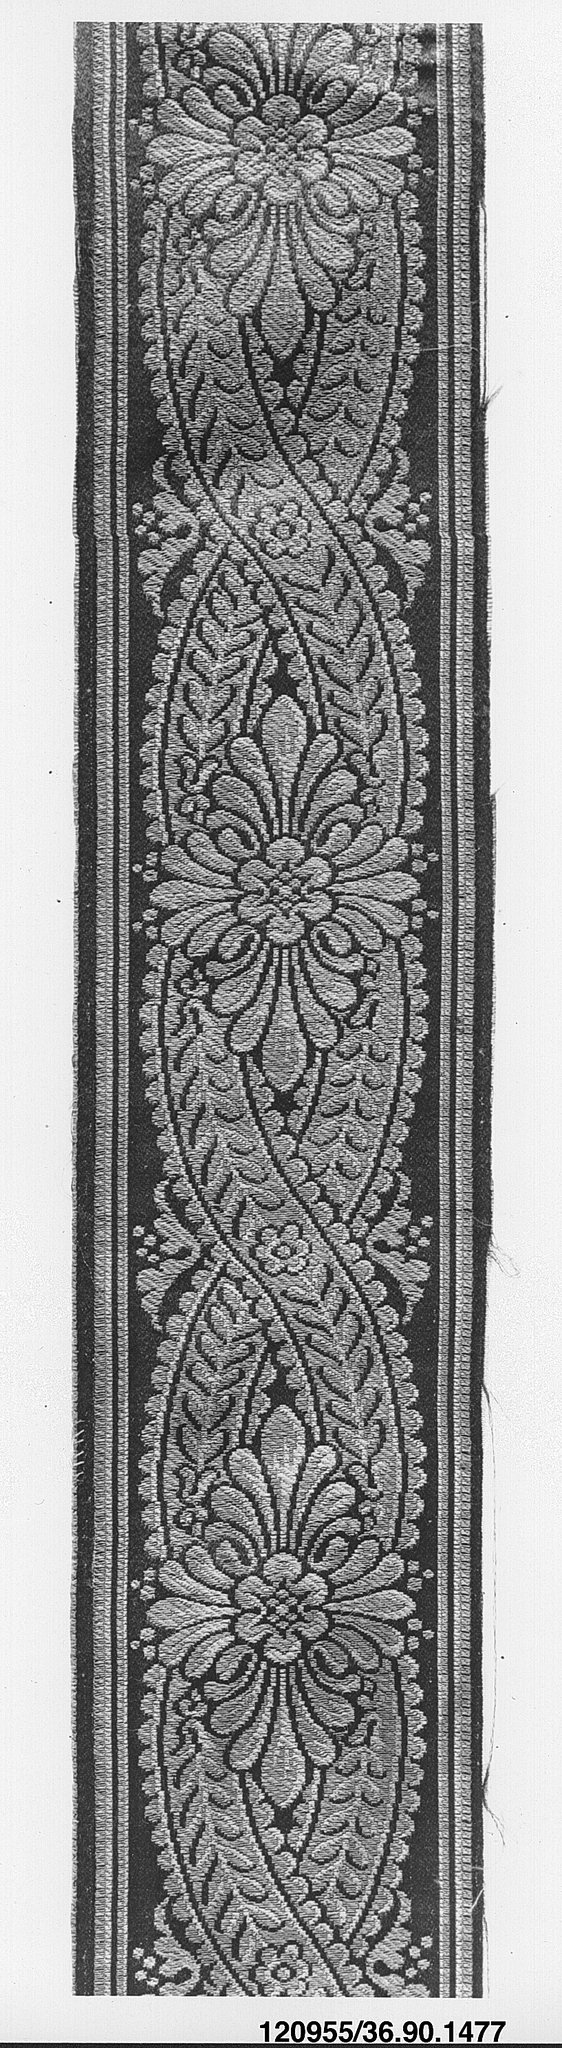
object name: band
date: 1801-1900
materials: silk